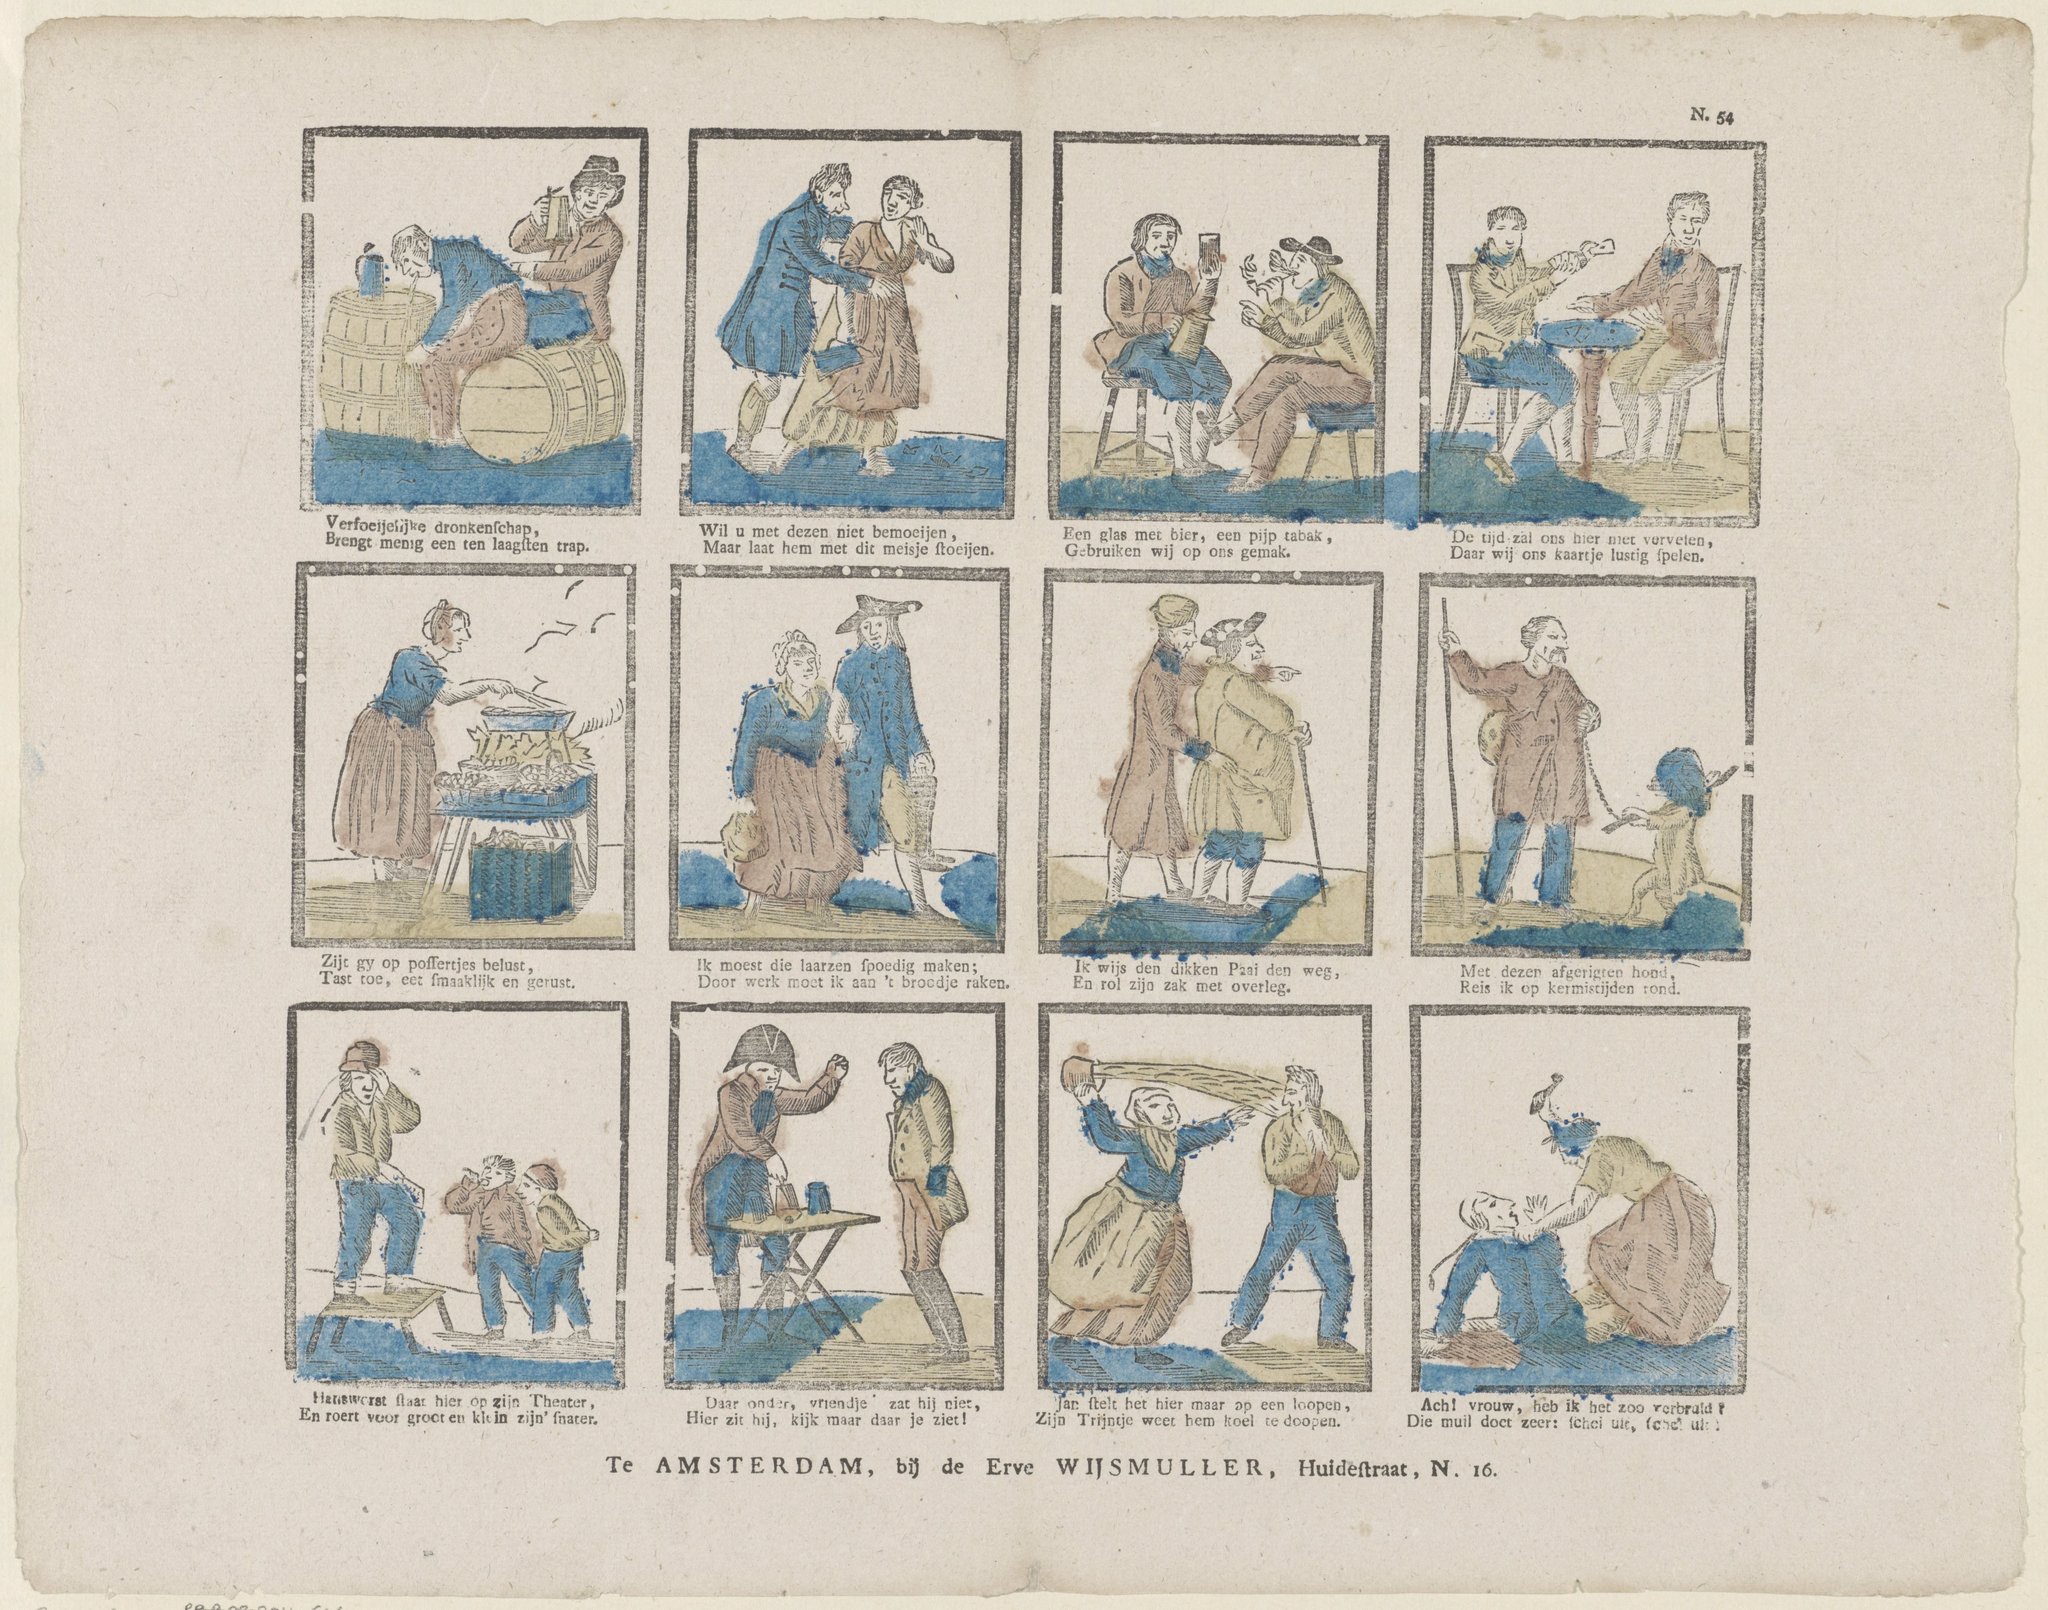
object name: print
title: Figuren en bezigheden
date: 1828-1849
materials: paper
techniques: colour, letterpress printing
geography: amsterdam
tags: human types, drunkard, working class, labourers, pickpocket, drunkenness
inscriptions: collector's mark: Lugt 2760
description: Blad met 12 voorstellingen van verschillende figuren en bezigheden, zoals een dronkenlap, een vrouw die poffertjes bakt en een zakkenroller. Onder elke voorstelling een tweeregelig vers. Genummerd rechtsboven: N. 54.